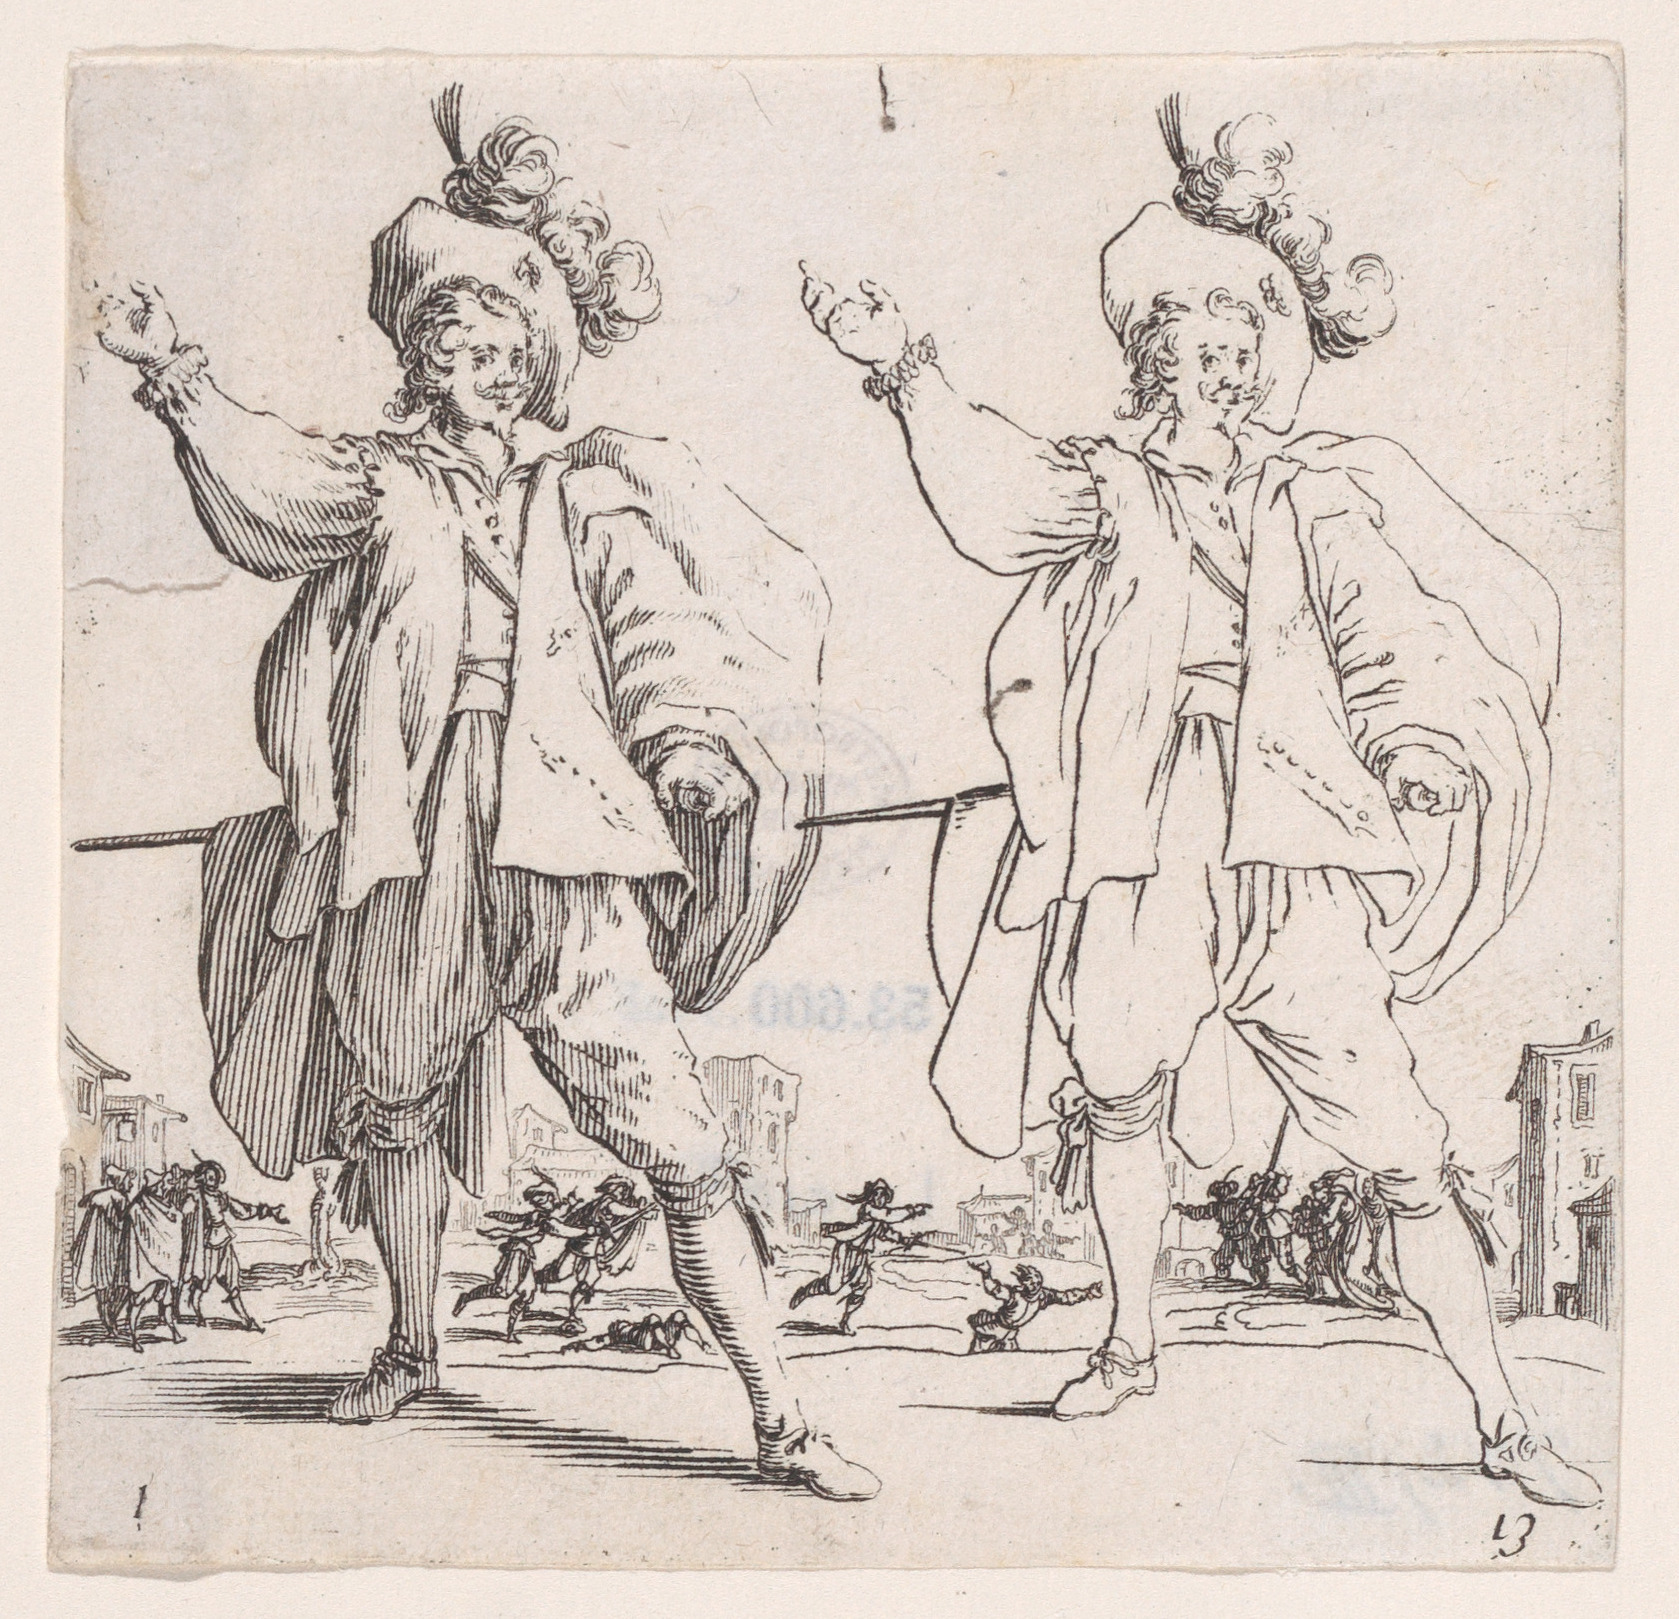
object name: print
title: L'Officier Tenant son Épée Horizontale (The Officer Holding his Sword Horizontally), plate 13 from "Varie Figure" (Various Figures)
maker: jacques callot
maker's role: artist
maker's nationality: french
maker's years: 1592-1635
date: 1620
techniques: etching